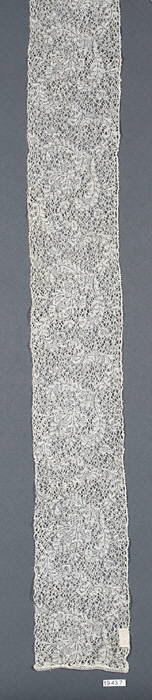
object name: piece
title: Piece (one of three)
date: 1701-1800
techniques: lace